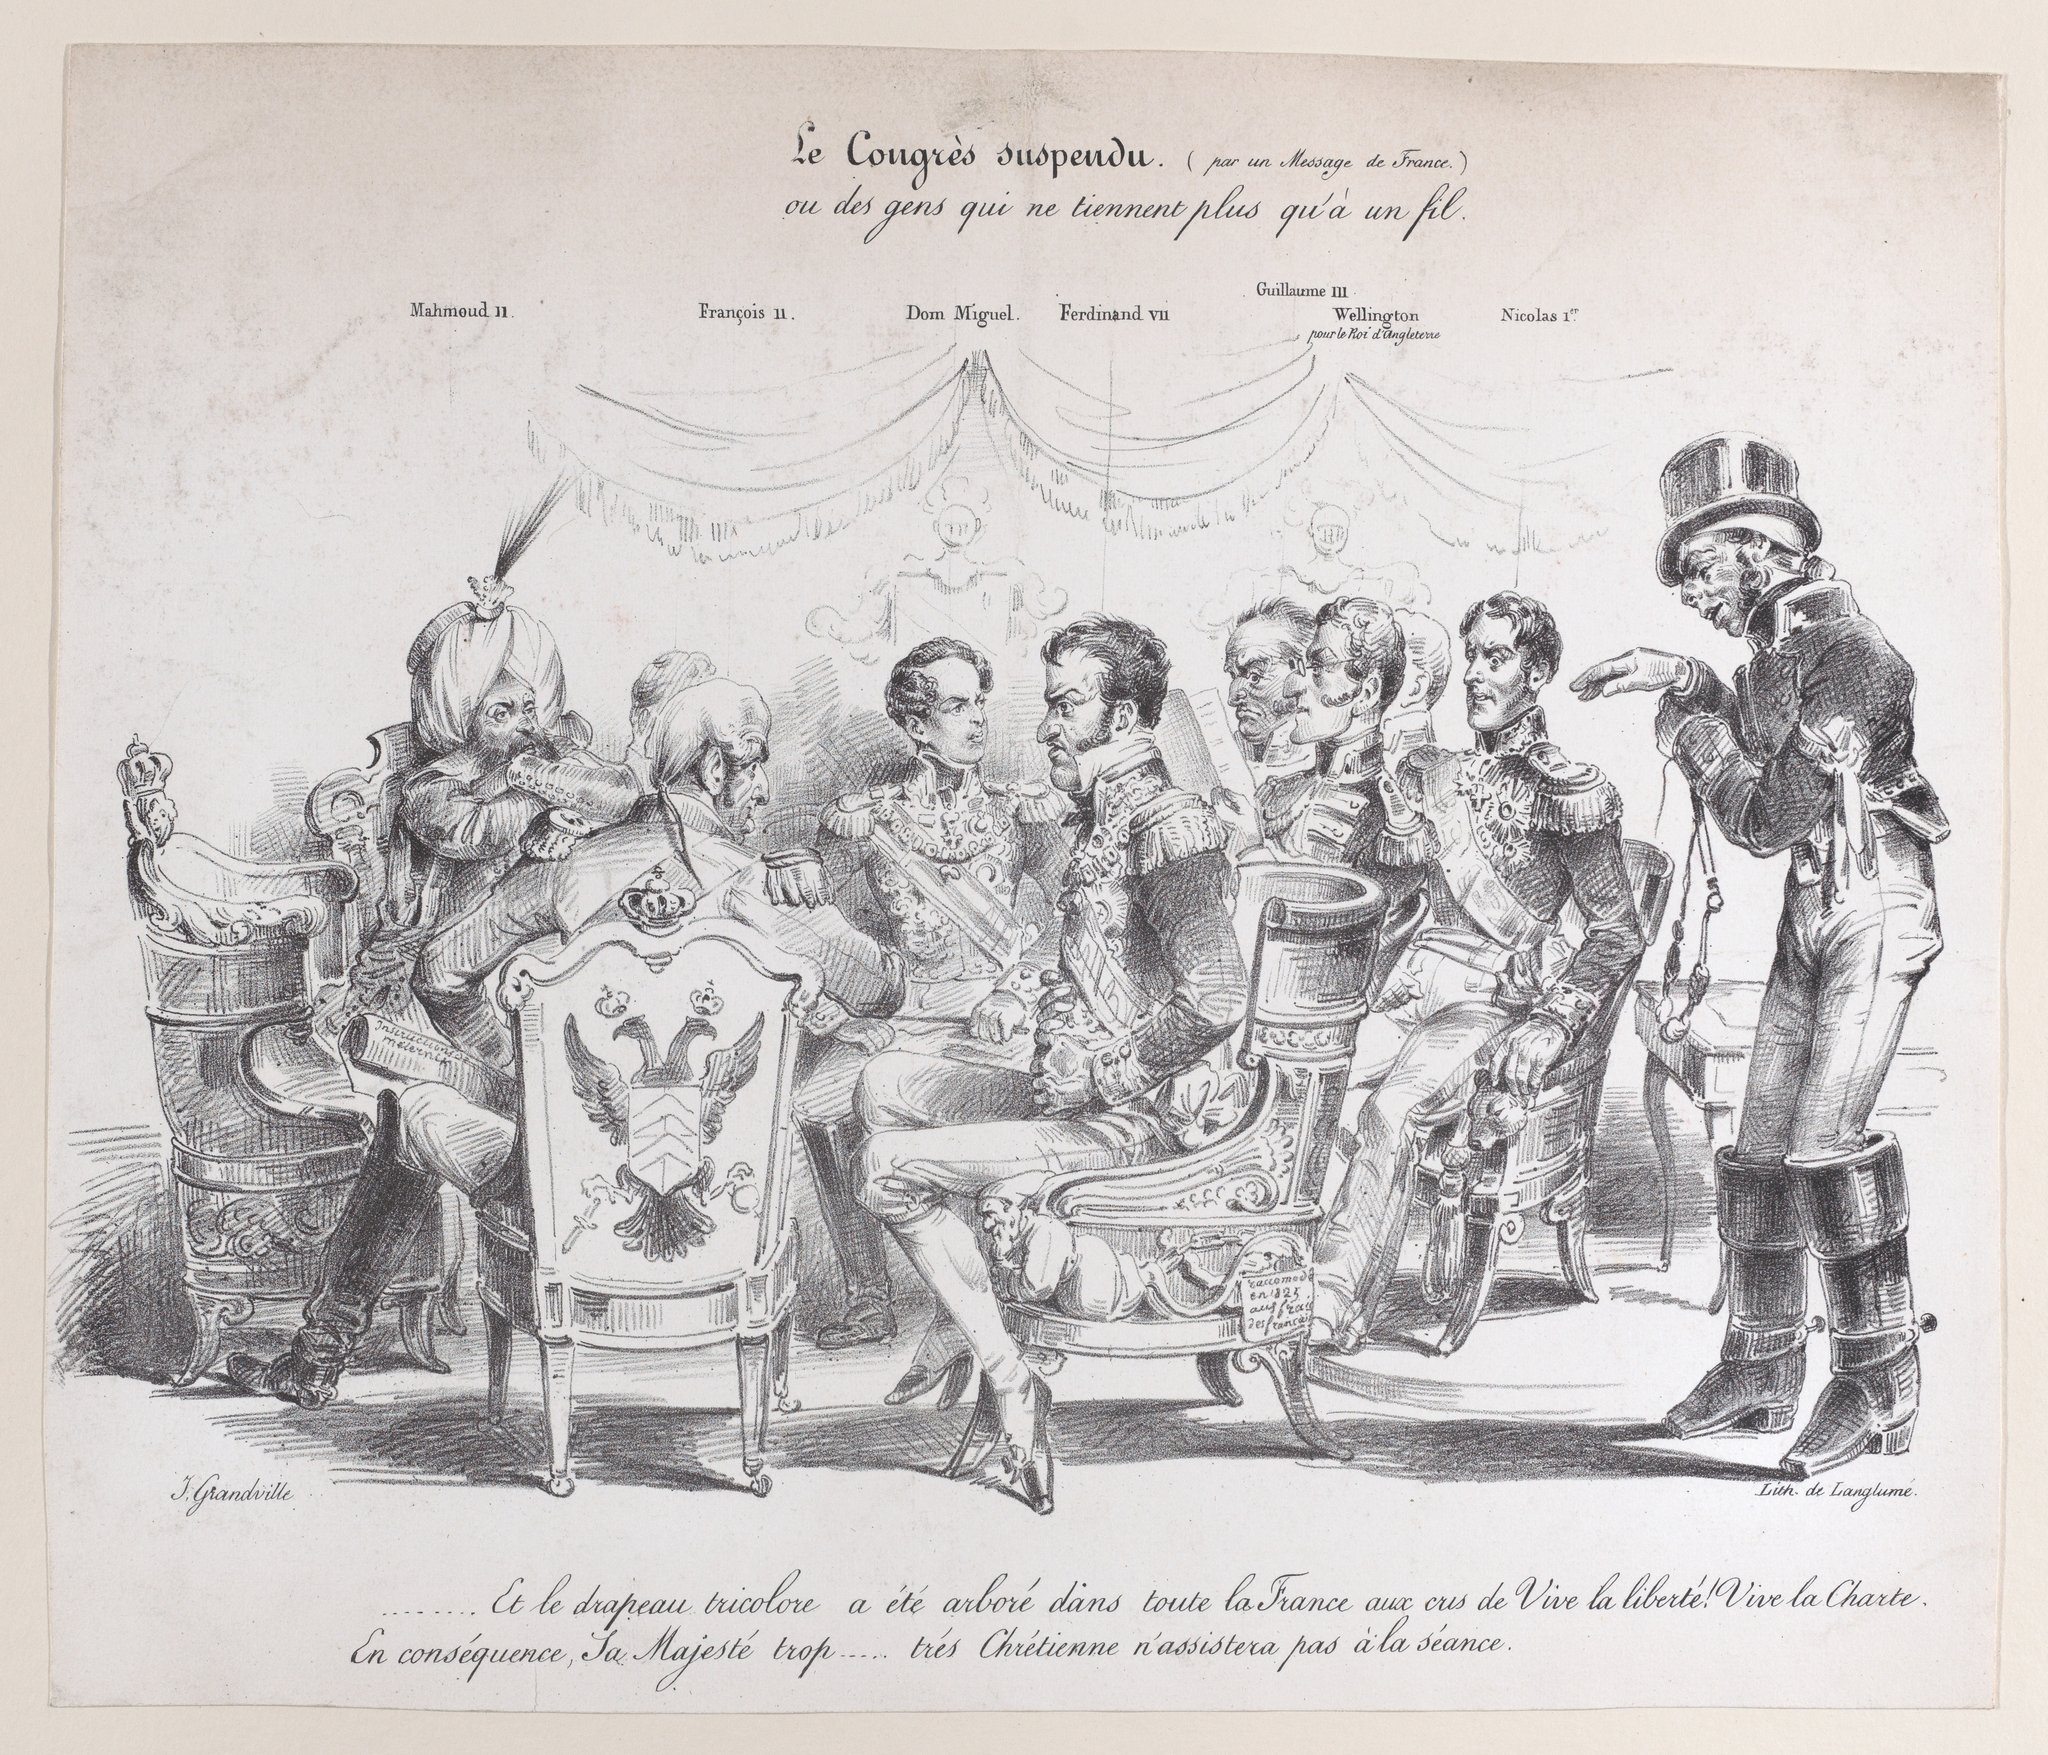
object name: print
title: The Suspended Congress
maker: j. j. grandville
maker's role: designer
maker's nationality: french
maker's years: 1803-1847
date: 1829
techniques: lithograph